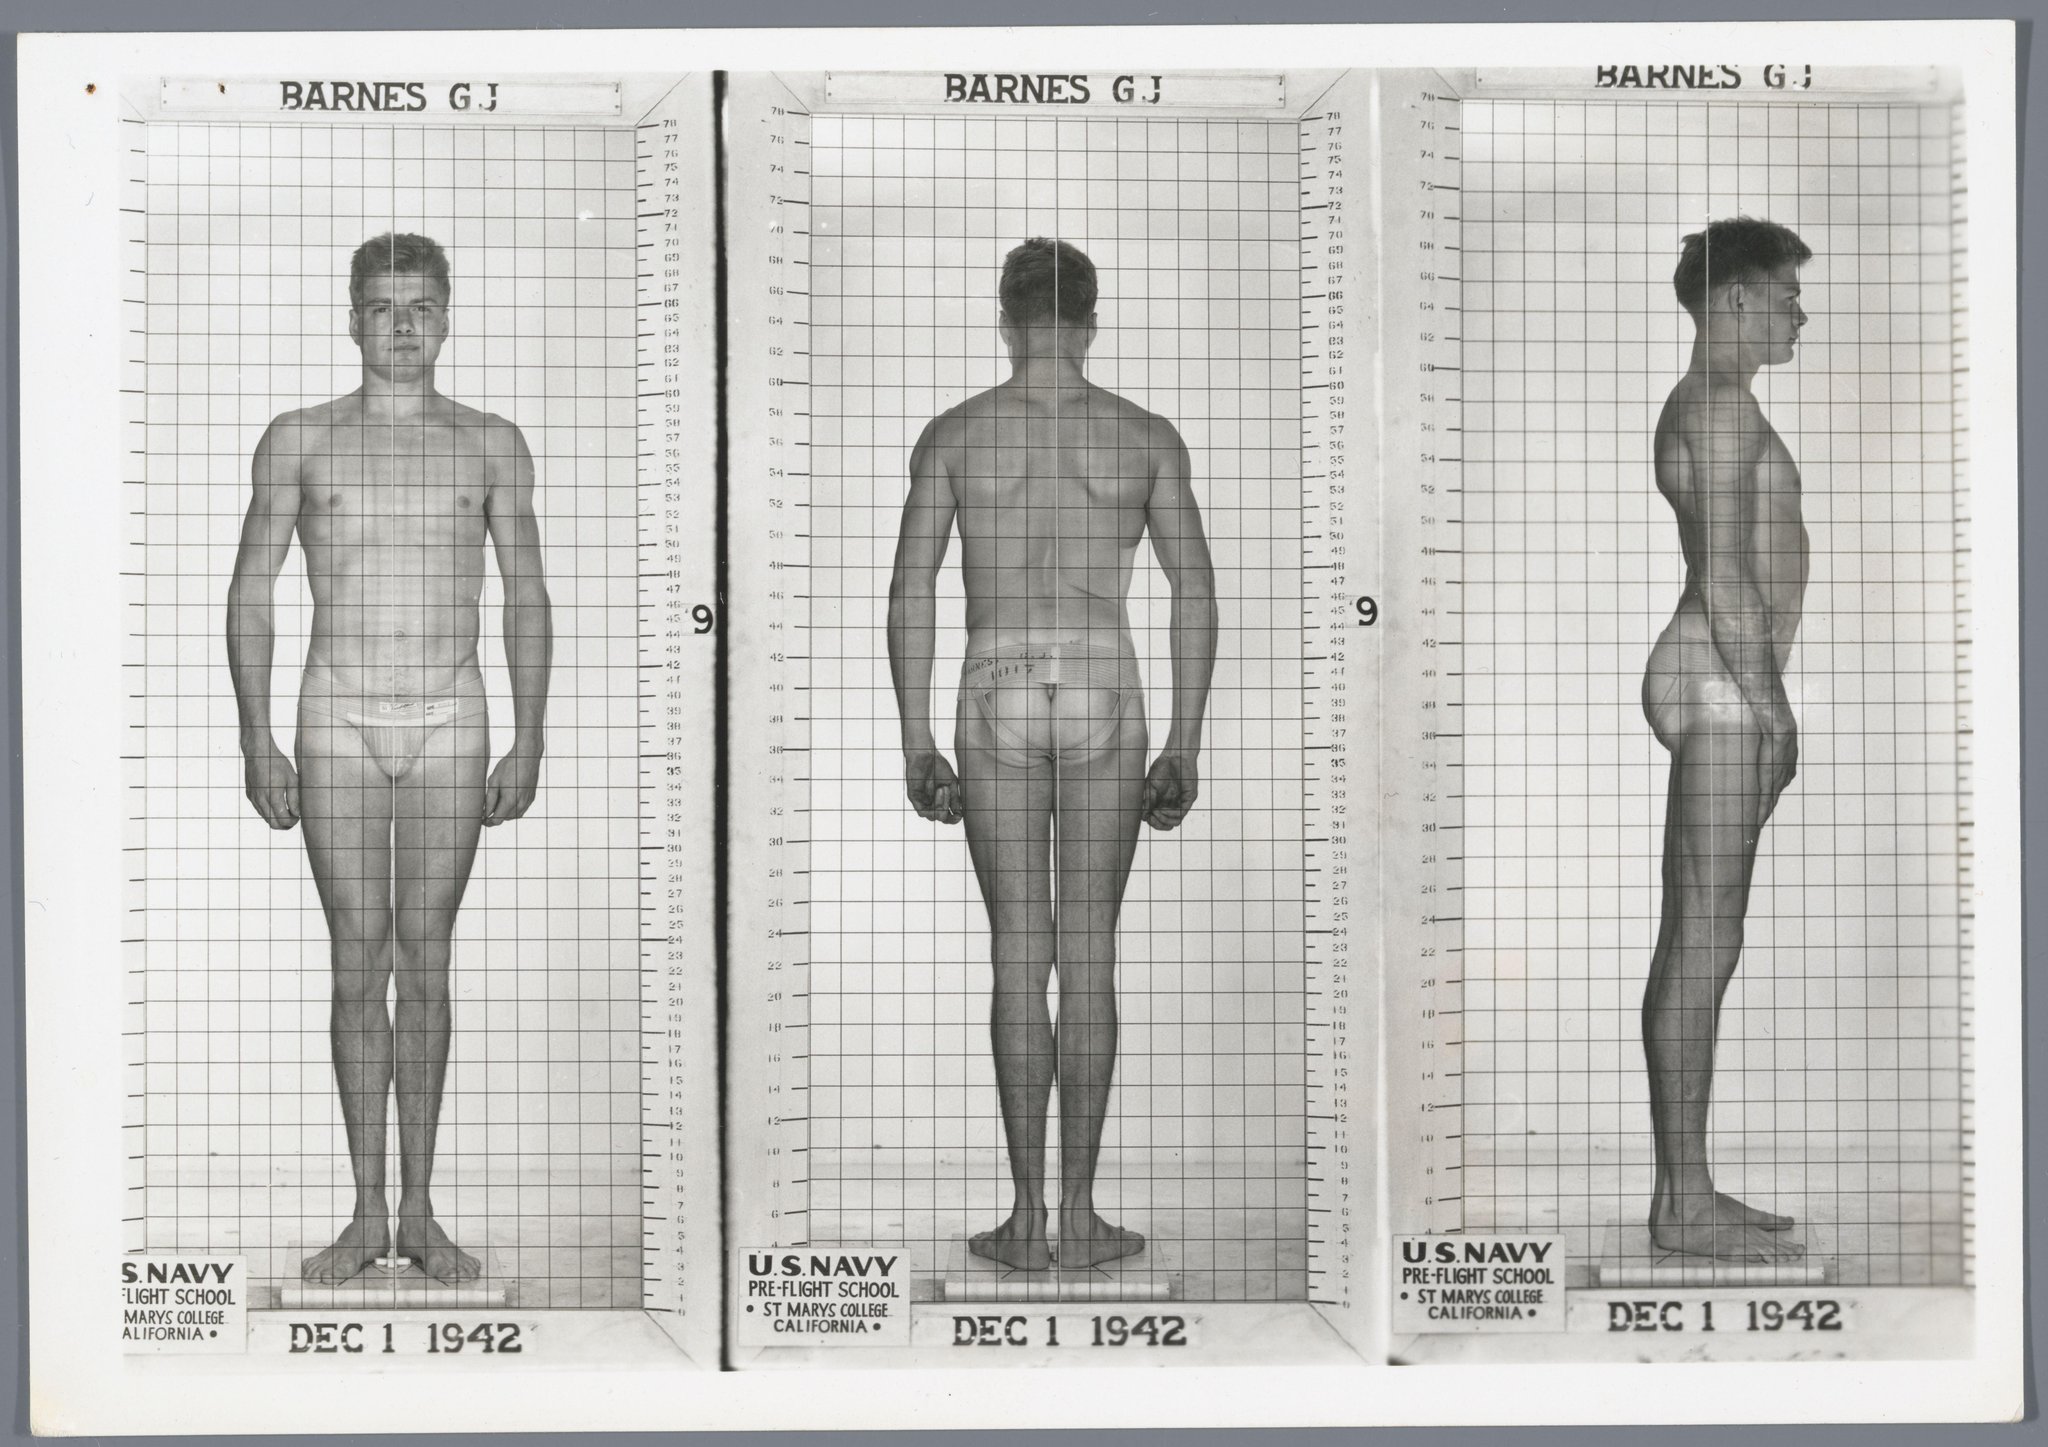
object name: photograph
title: US Navy Pre-Flight School St. Mary’s College of California (Moraga, CA), Drie foto’s van G.J. Barnes tijdens zijn opleiding tot militair vliegenier, gezien van voren, achteren en opzij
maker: Anonymous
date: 1942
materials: paper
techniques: gelatin silver print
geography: california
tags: the (nude) human figure; 'corpo humano' (ripa), historical persons, medical examination, medical treatment